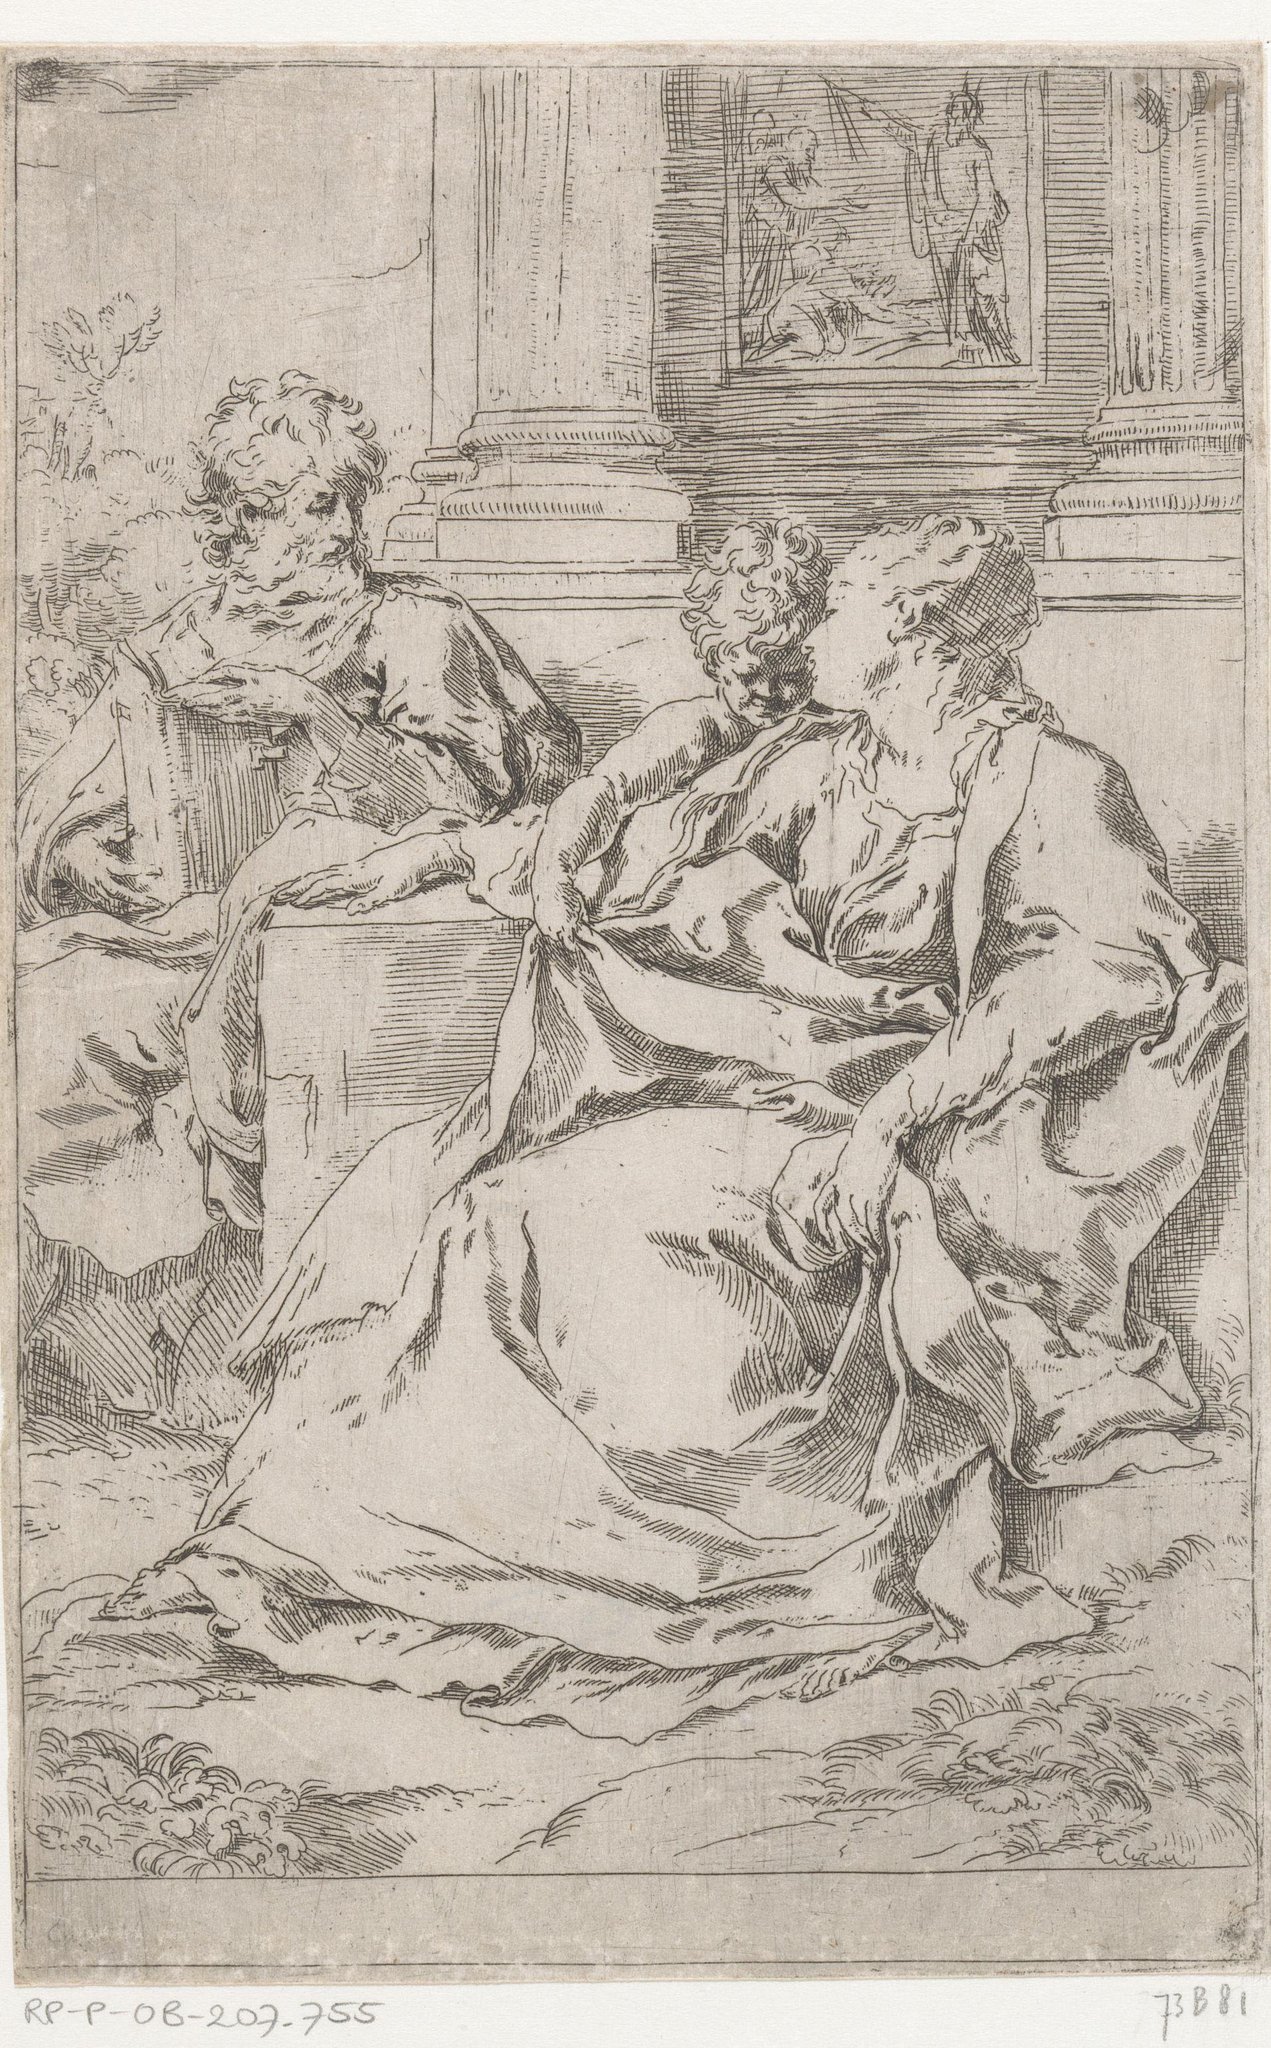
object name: print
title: Heilige Familie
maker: guido reni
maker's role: draughtsman, painter, print maker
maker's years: 1575-1642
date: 1585-1642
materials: paper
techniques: etching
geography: italy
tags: holy family, and derived representations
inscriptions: collector's mark: Lugt 2228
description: De Heilige Familie rustend voor een bouwwerk met pilasters.